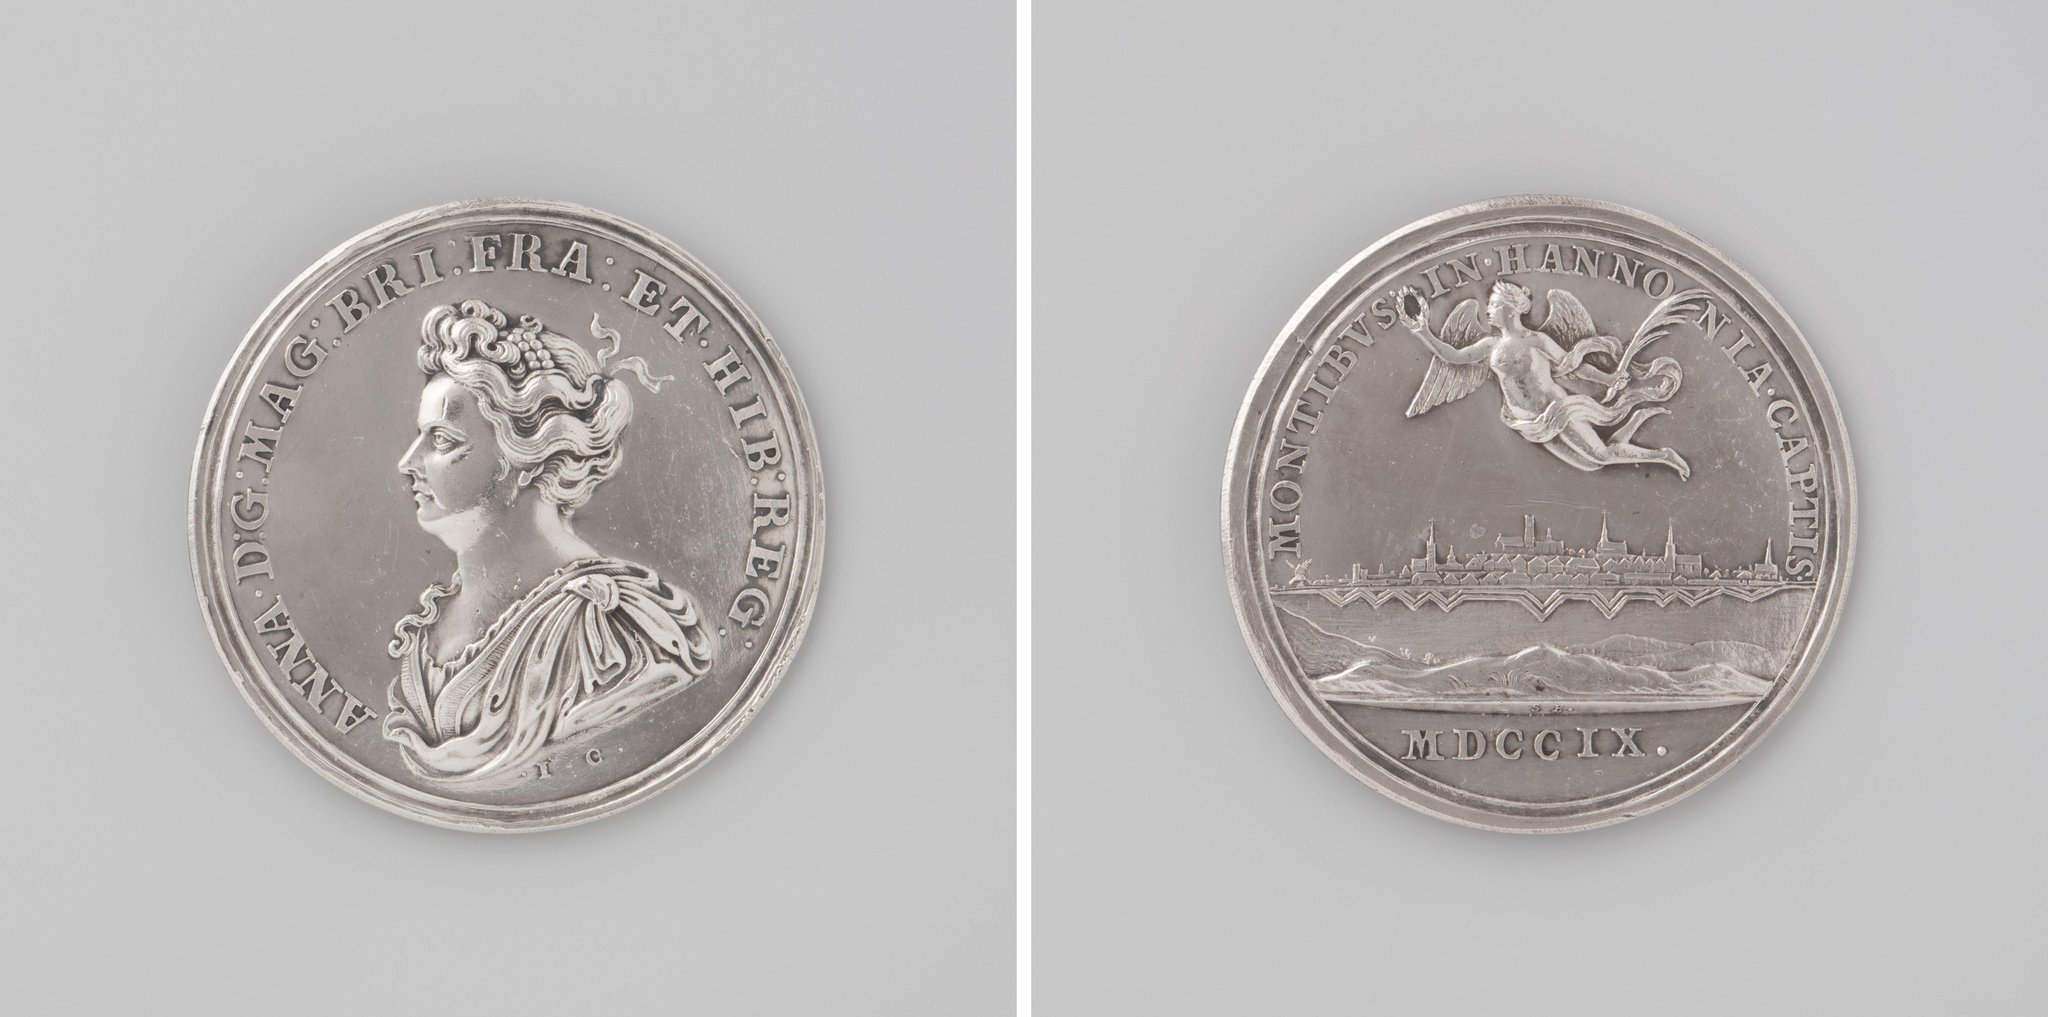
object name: history medal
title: Inname van Bergen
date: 1709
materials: silver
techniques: striking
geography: london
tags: london, anna stuart (koningin van engeland en schotland), henegouwen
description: Zilveren penning. Voorzijde: borststuk vrouw met kroon binnen omschrift. Keerzijde: Overwinning met palmtak en lauwerkrans vliegend over stad Bergen binnen omschrift, boven opschrift.